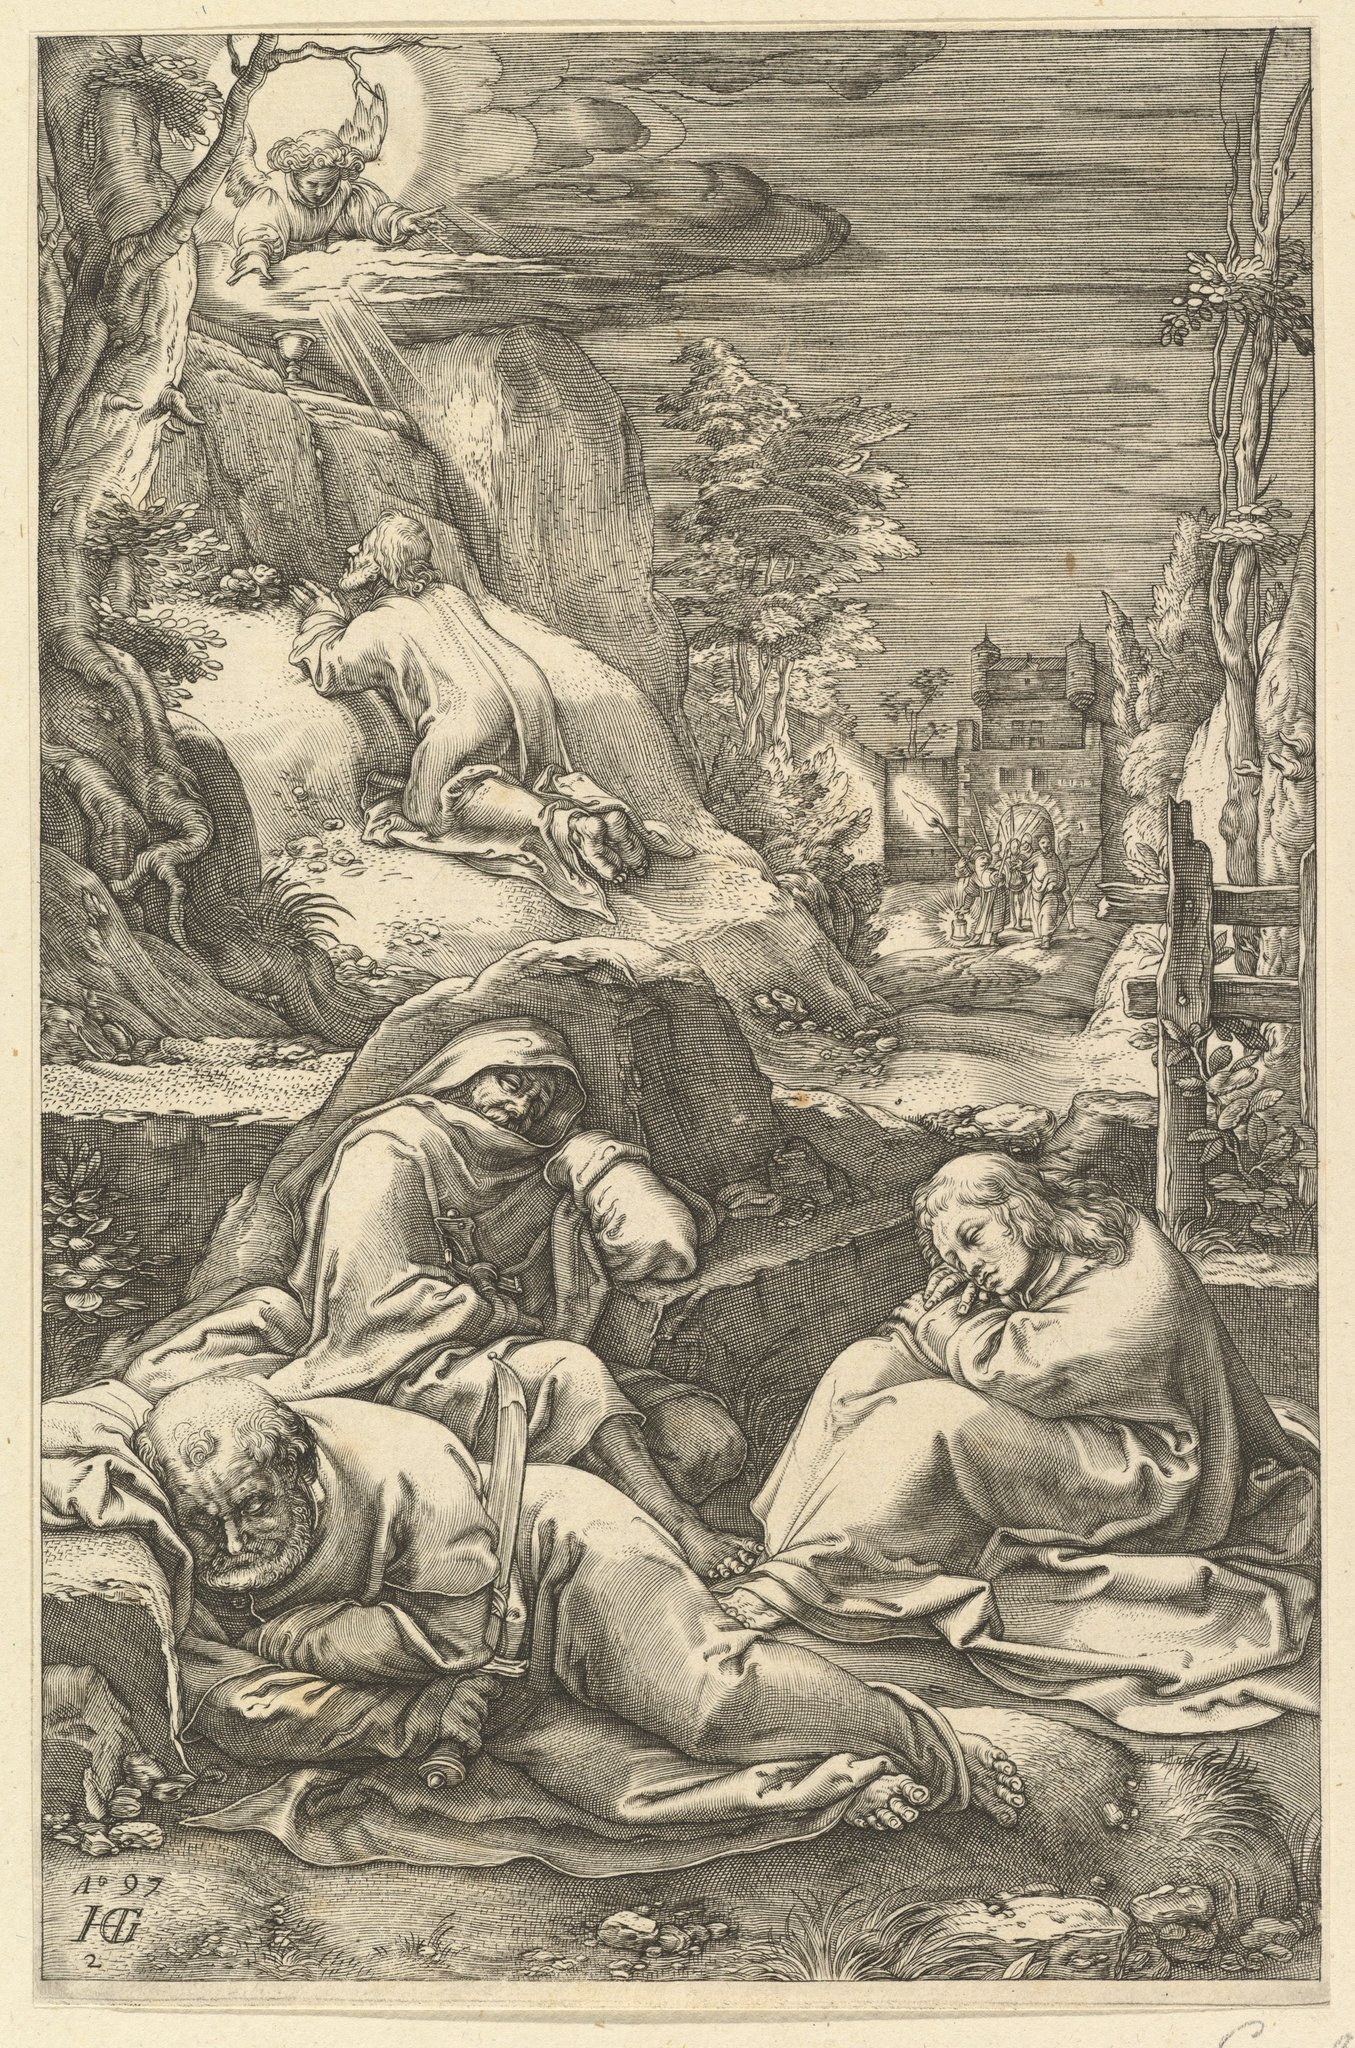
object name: print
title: The Agony in the Garden, from "The Passion of Christ"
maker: Anonymous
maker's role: artist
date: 1598-1617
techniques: engraving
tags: gardens,men,women,angels,christ